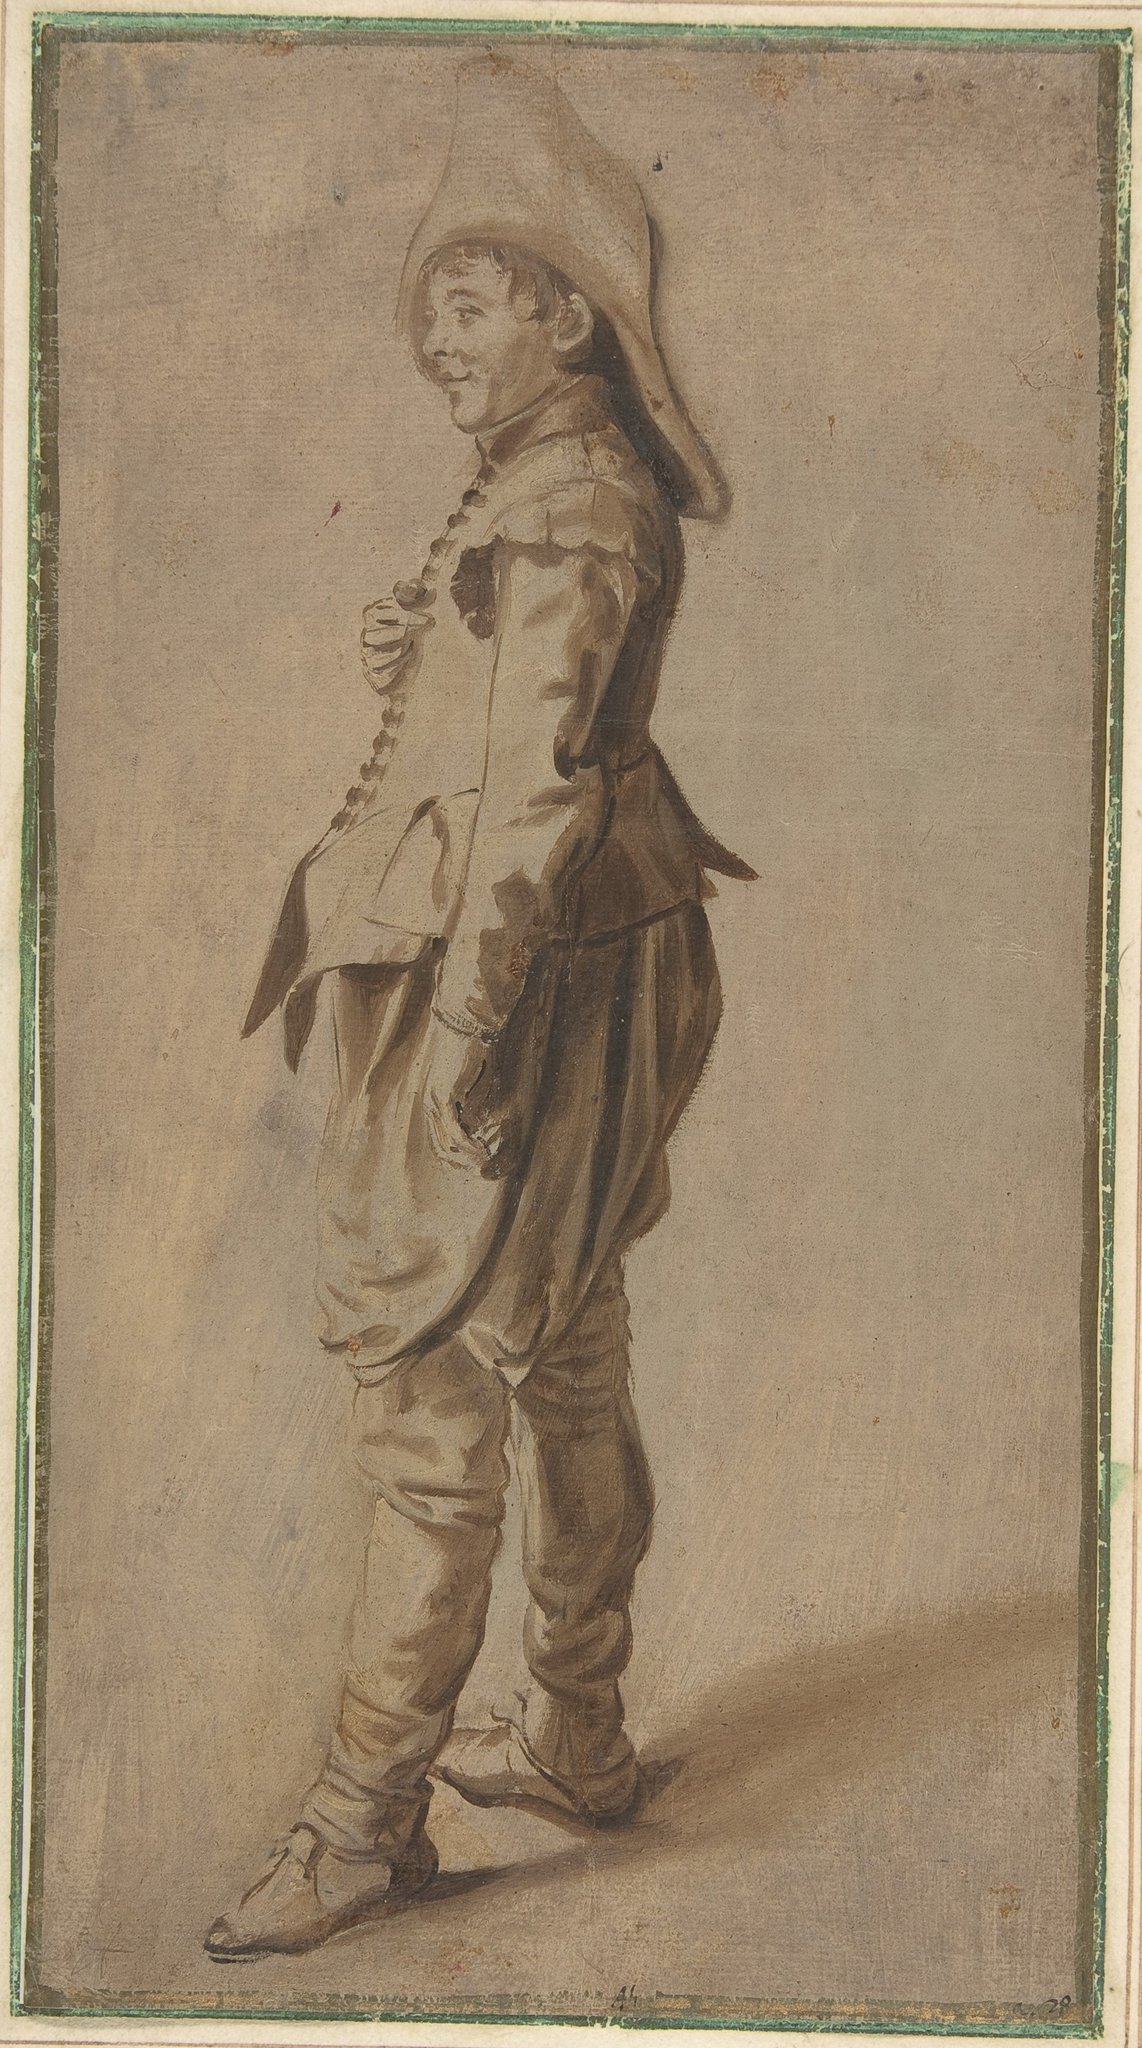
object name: drawing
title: Study of a Standing Youth in a Hat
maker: dirck hals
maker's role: artist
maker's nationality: dutch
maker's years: 1591-1656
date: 1601-1700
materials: oil, paper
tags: men,portraits